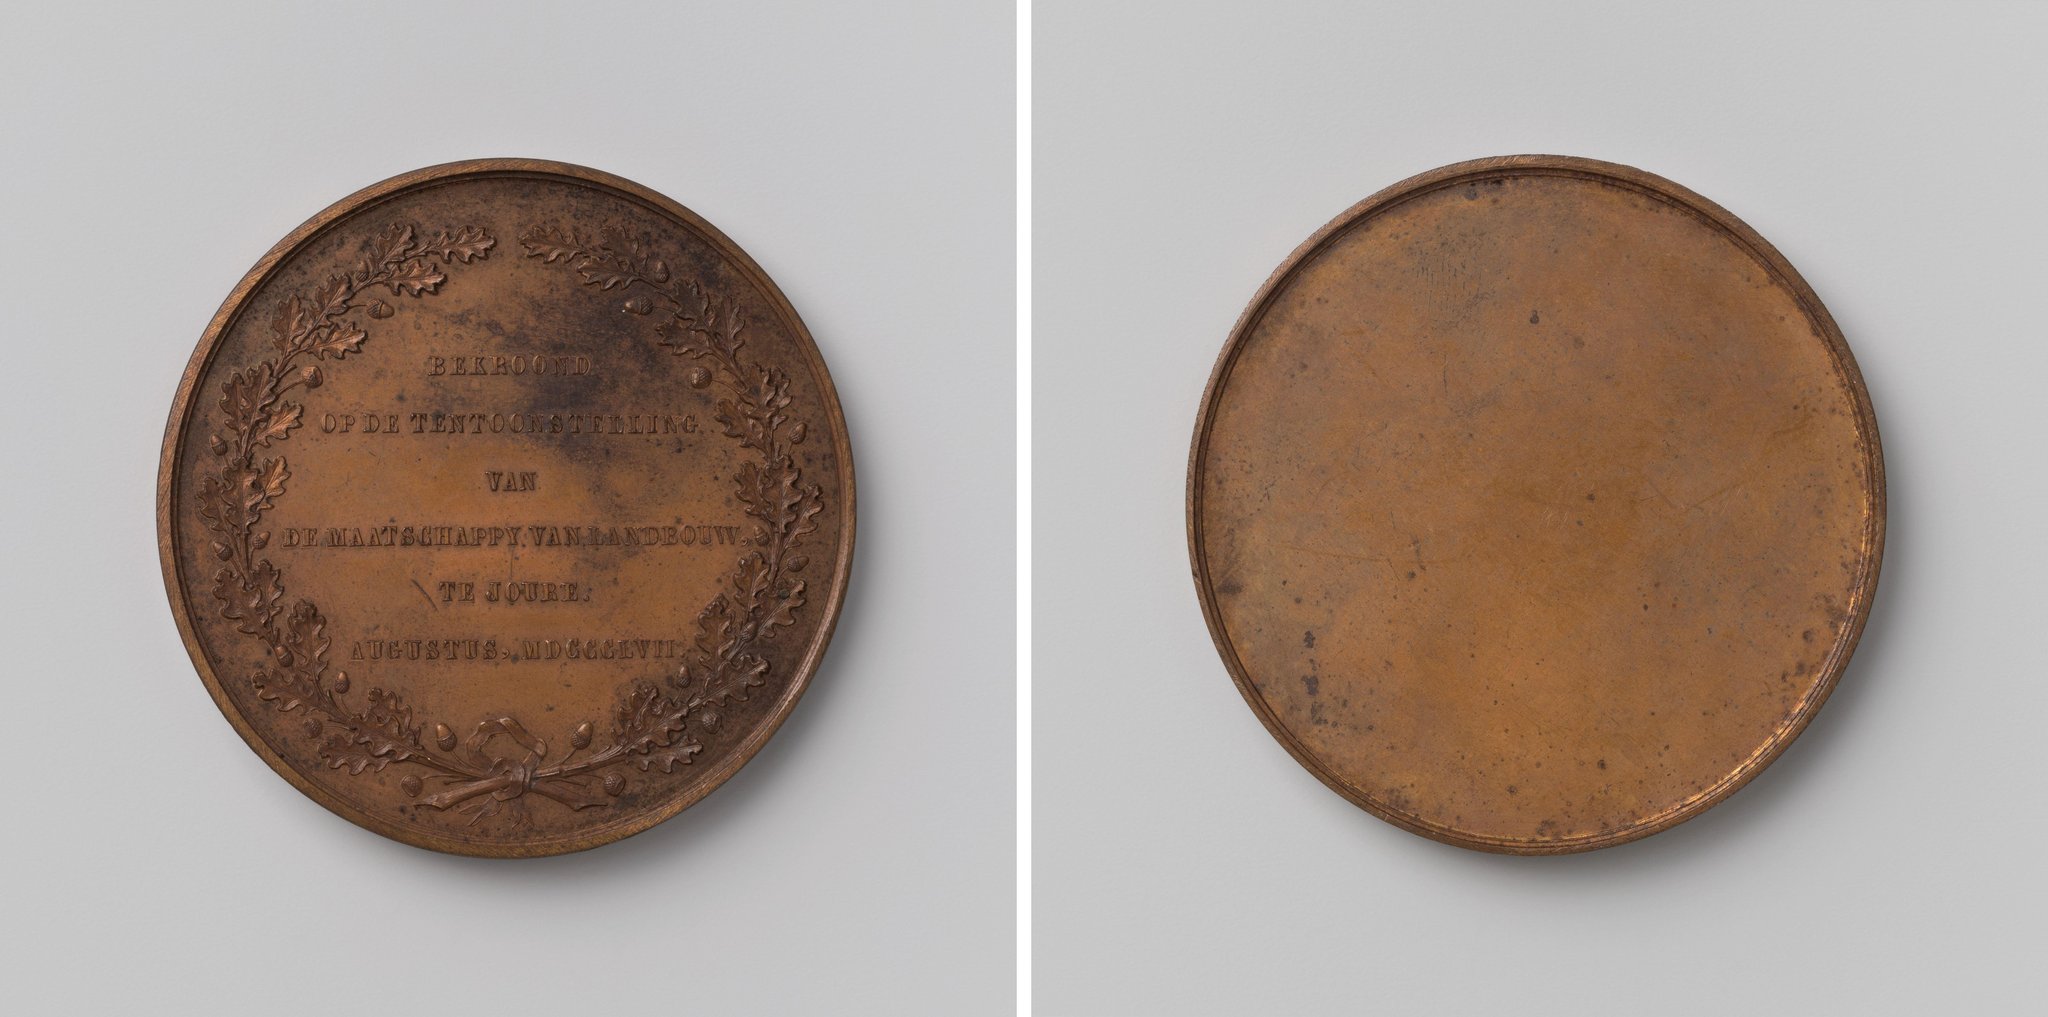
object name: medal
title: Tentoonstelling van de Maatschappij van Landbouw te Joure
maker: Anonymous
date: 1857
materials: bronze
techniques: striking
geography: netherlands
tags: leeuwarden, joure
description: Bronzen penning. Voorzijde: opschrift binnen eikekrans. Keerzijde: blanco